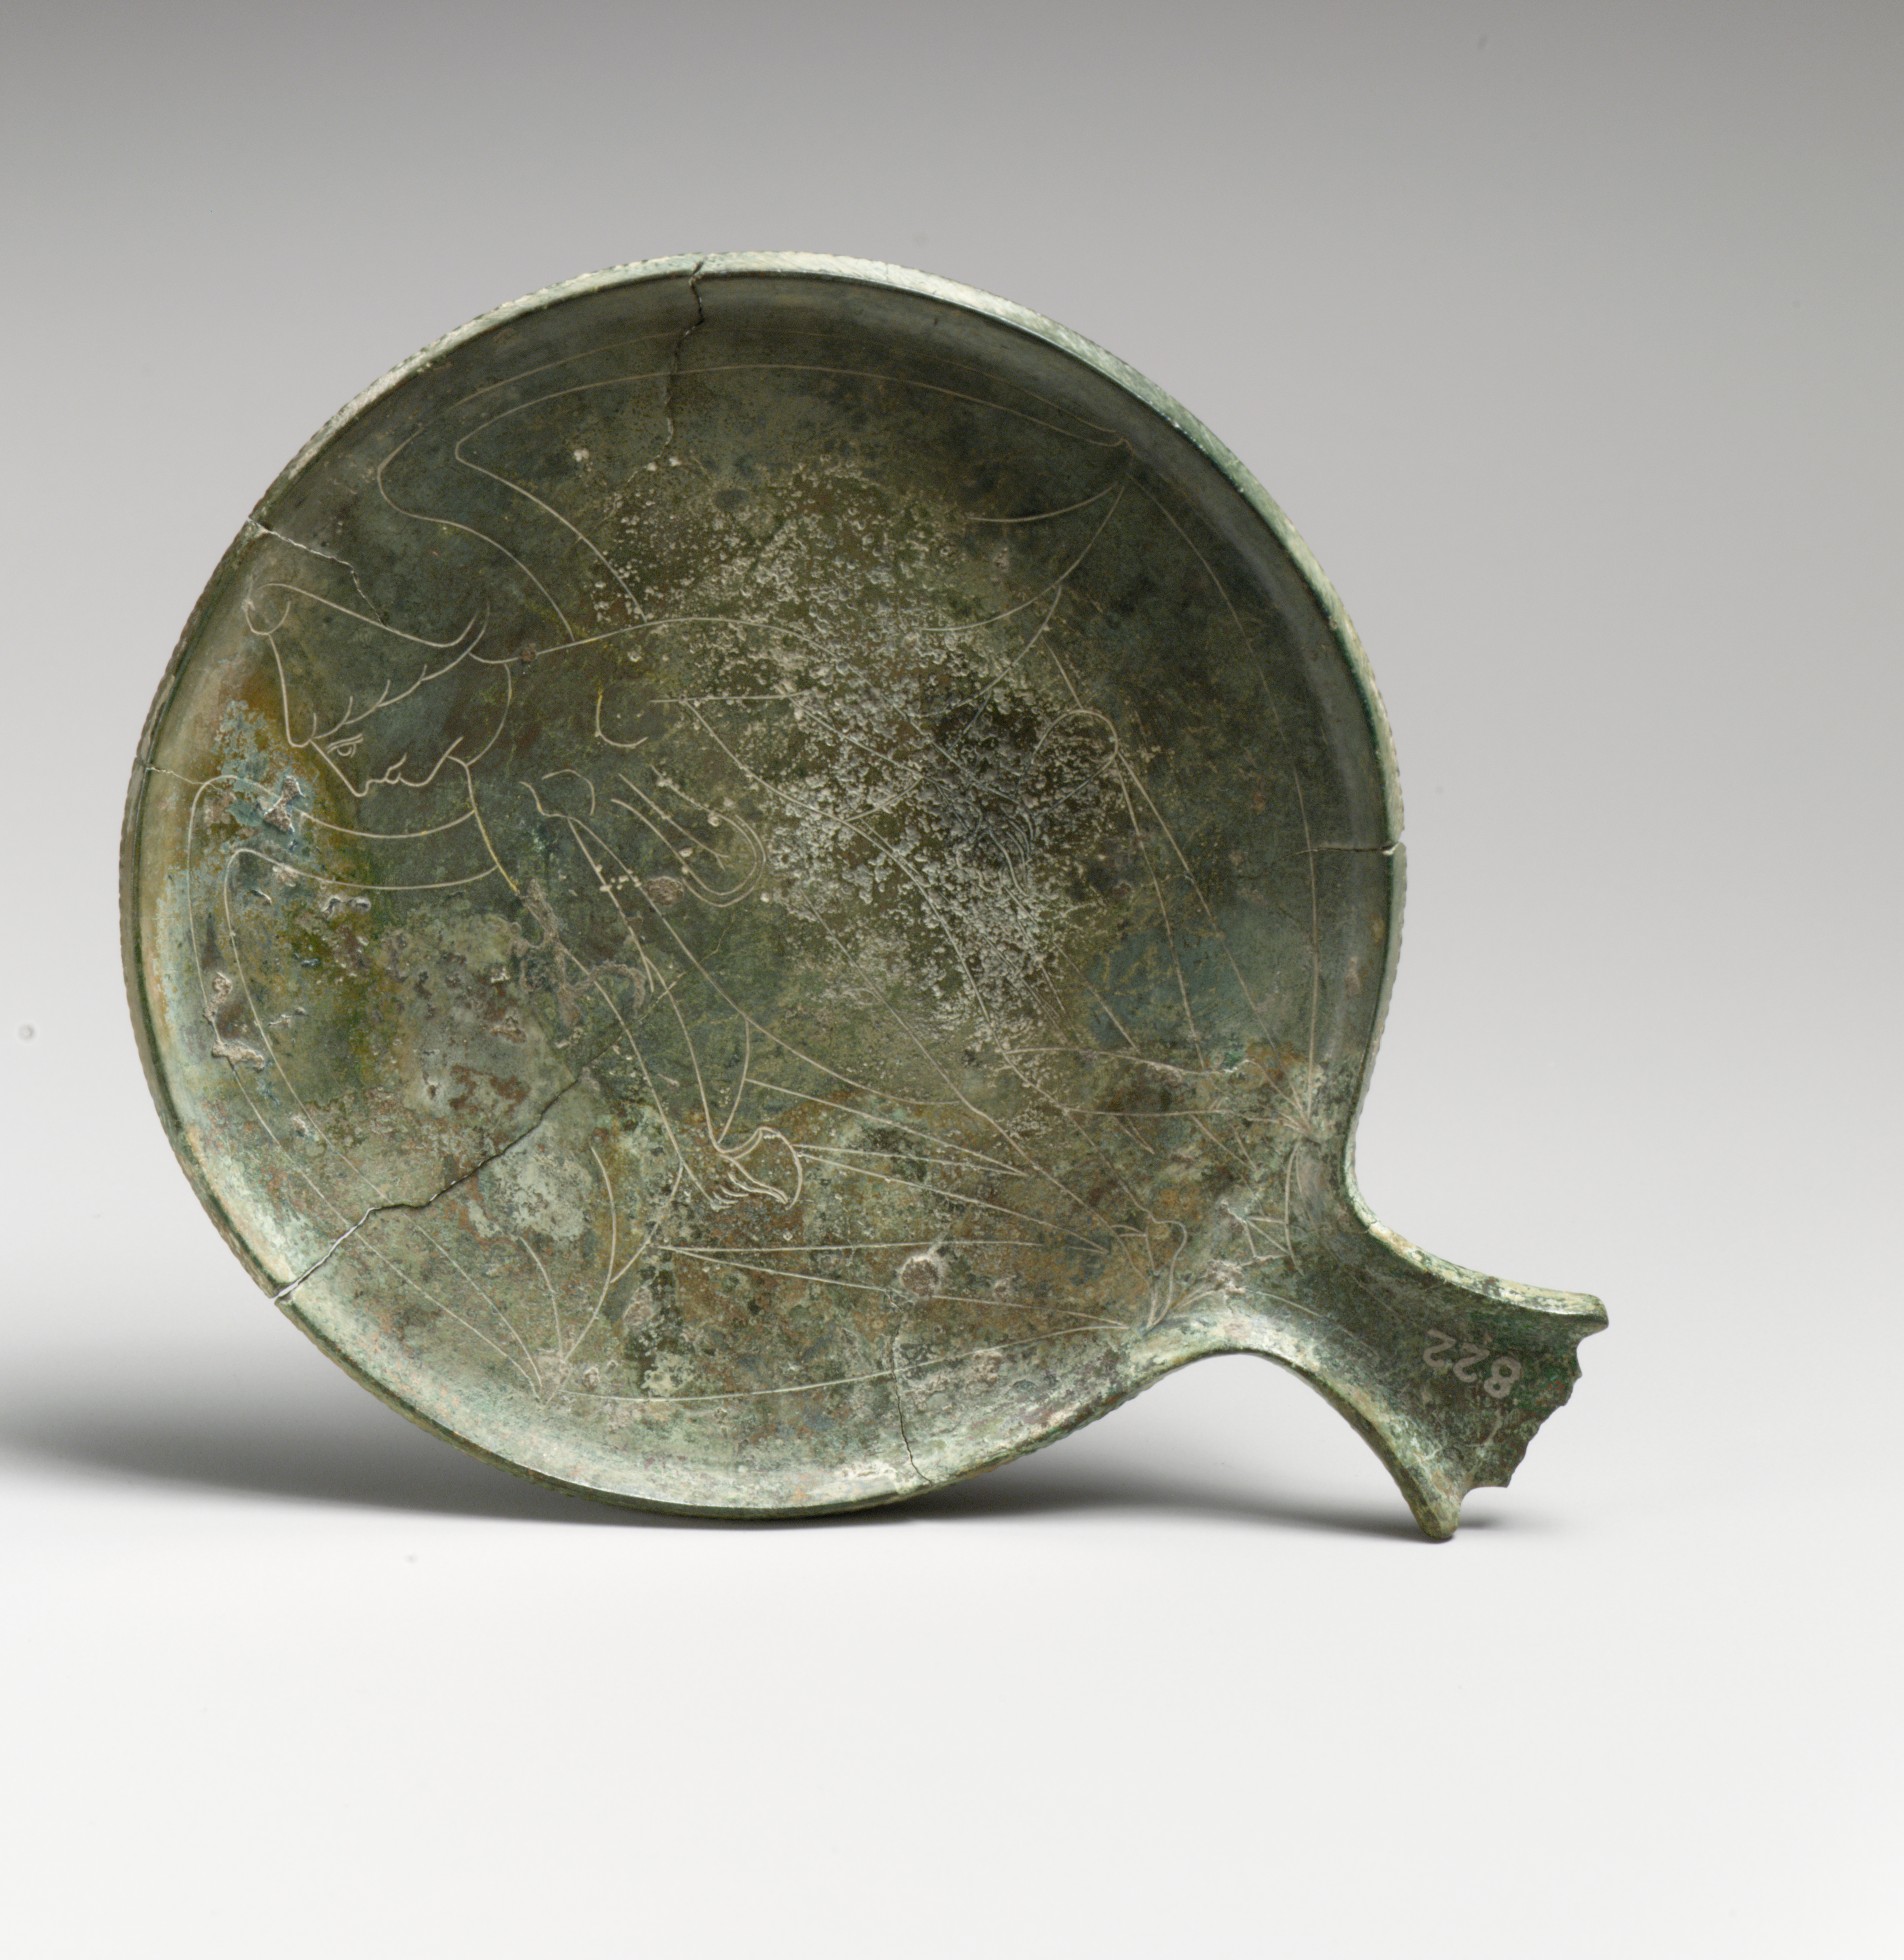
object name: mirror with lasa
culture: etruscan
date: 900-100 BCE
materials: bronze